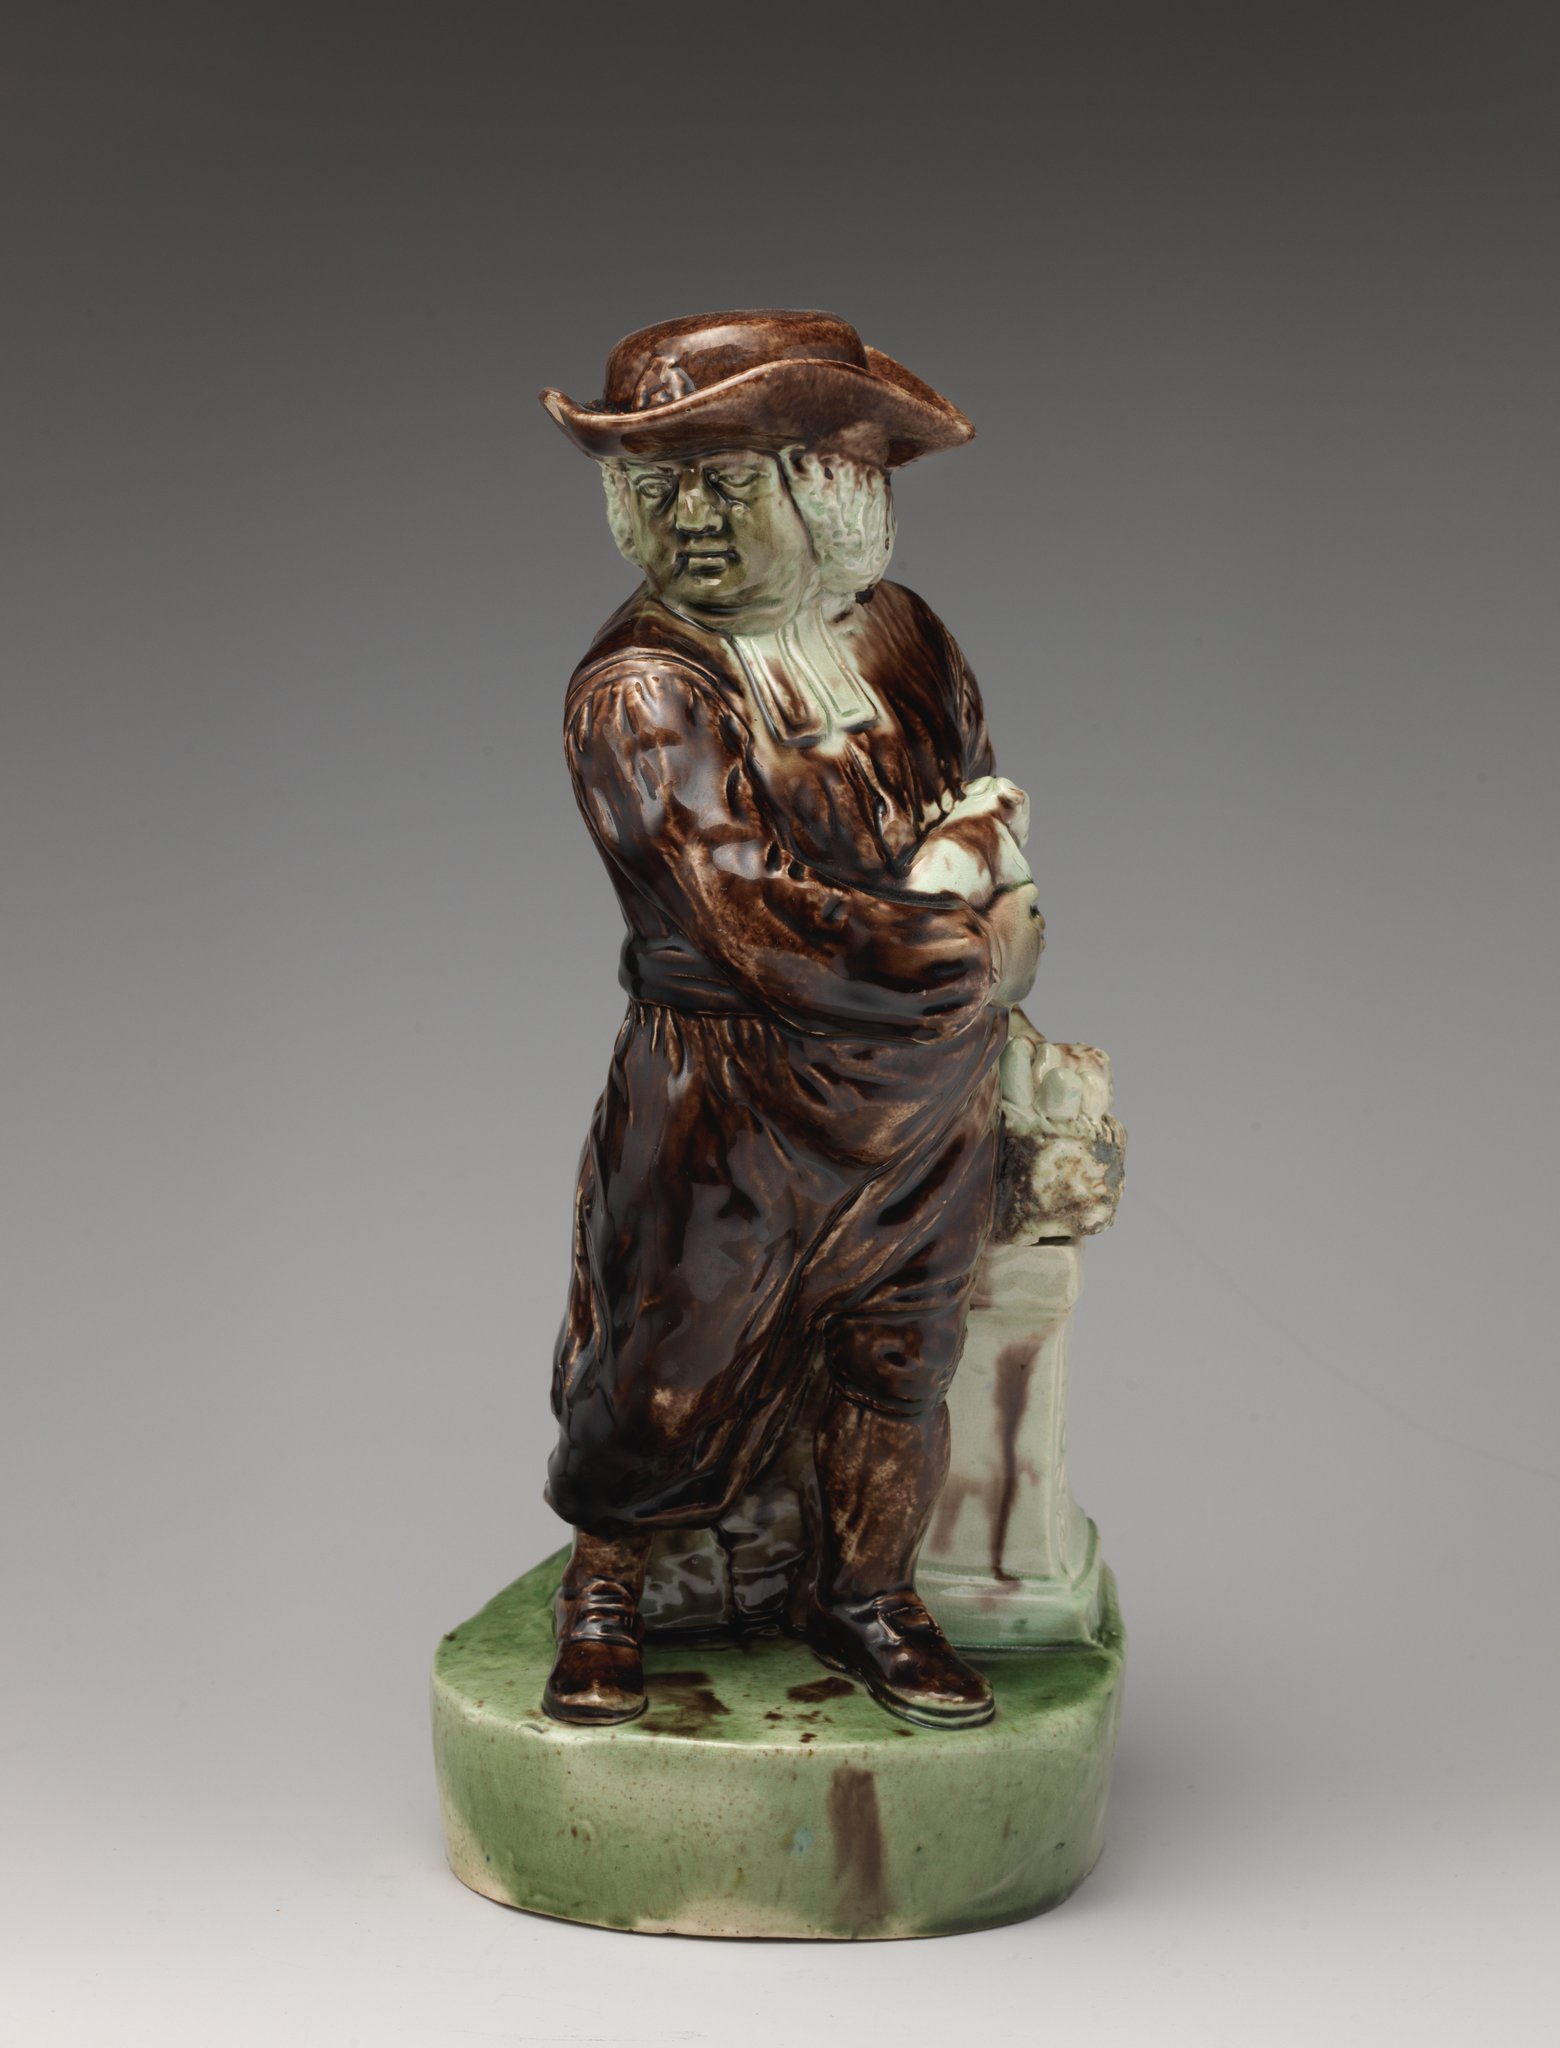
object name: figure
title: The Parson (part of a "Tithe Pig" group)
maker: ralph wood the younger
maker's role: maker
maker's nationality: british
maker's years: 1748-1795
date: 1770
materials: earthenware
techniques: glazing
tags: men